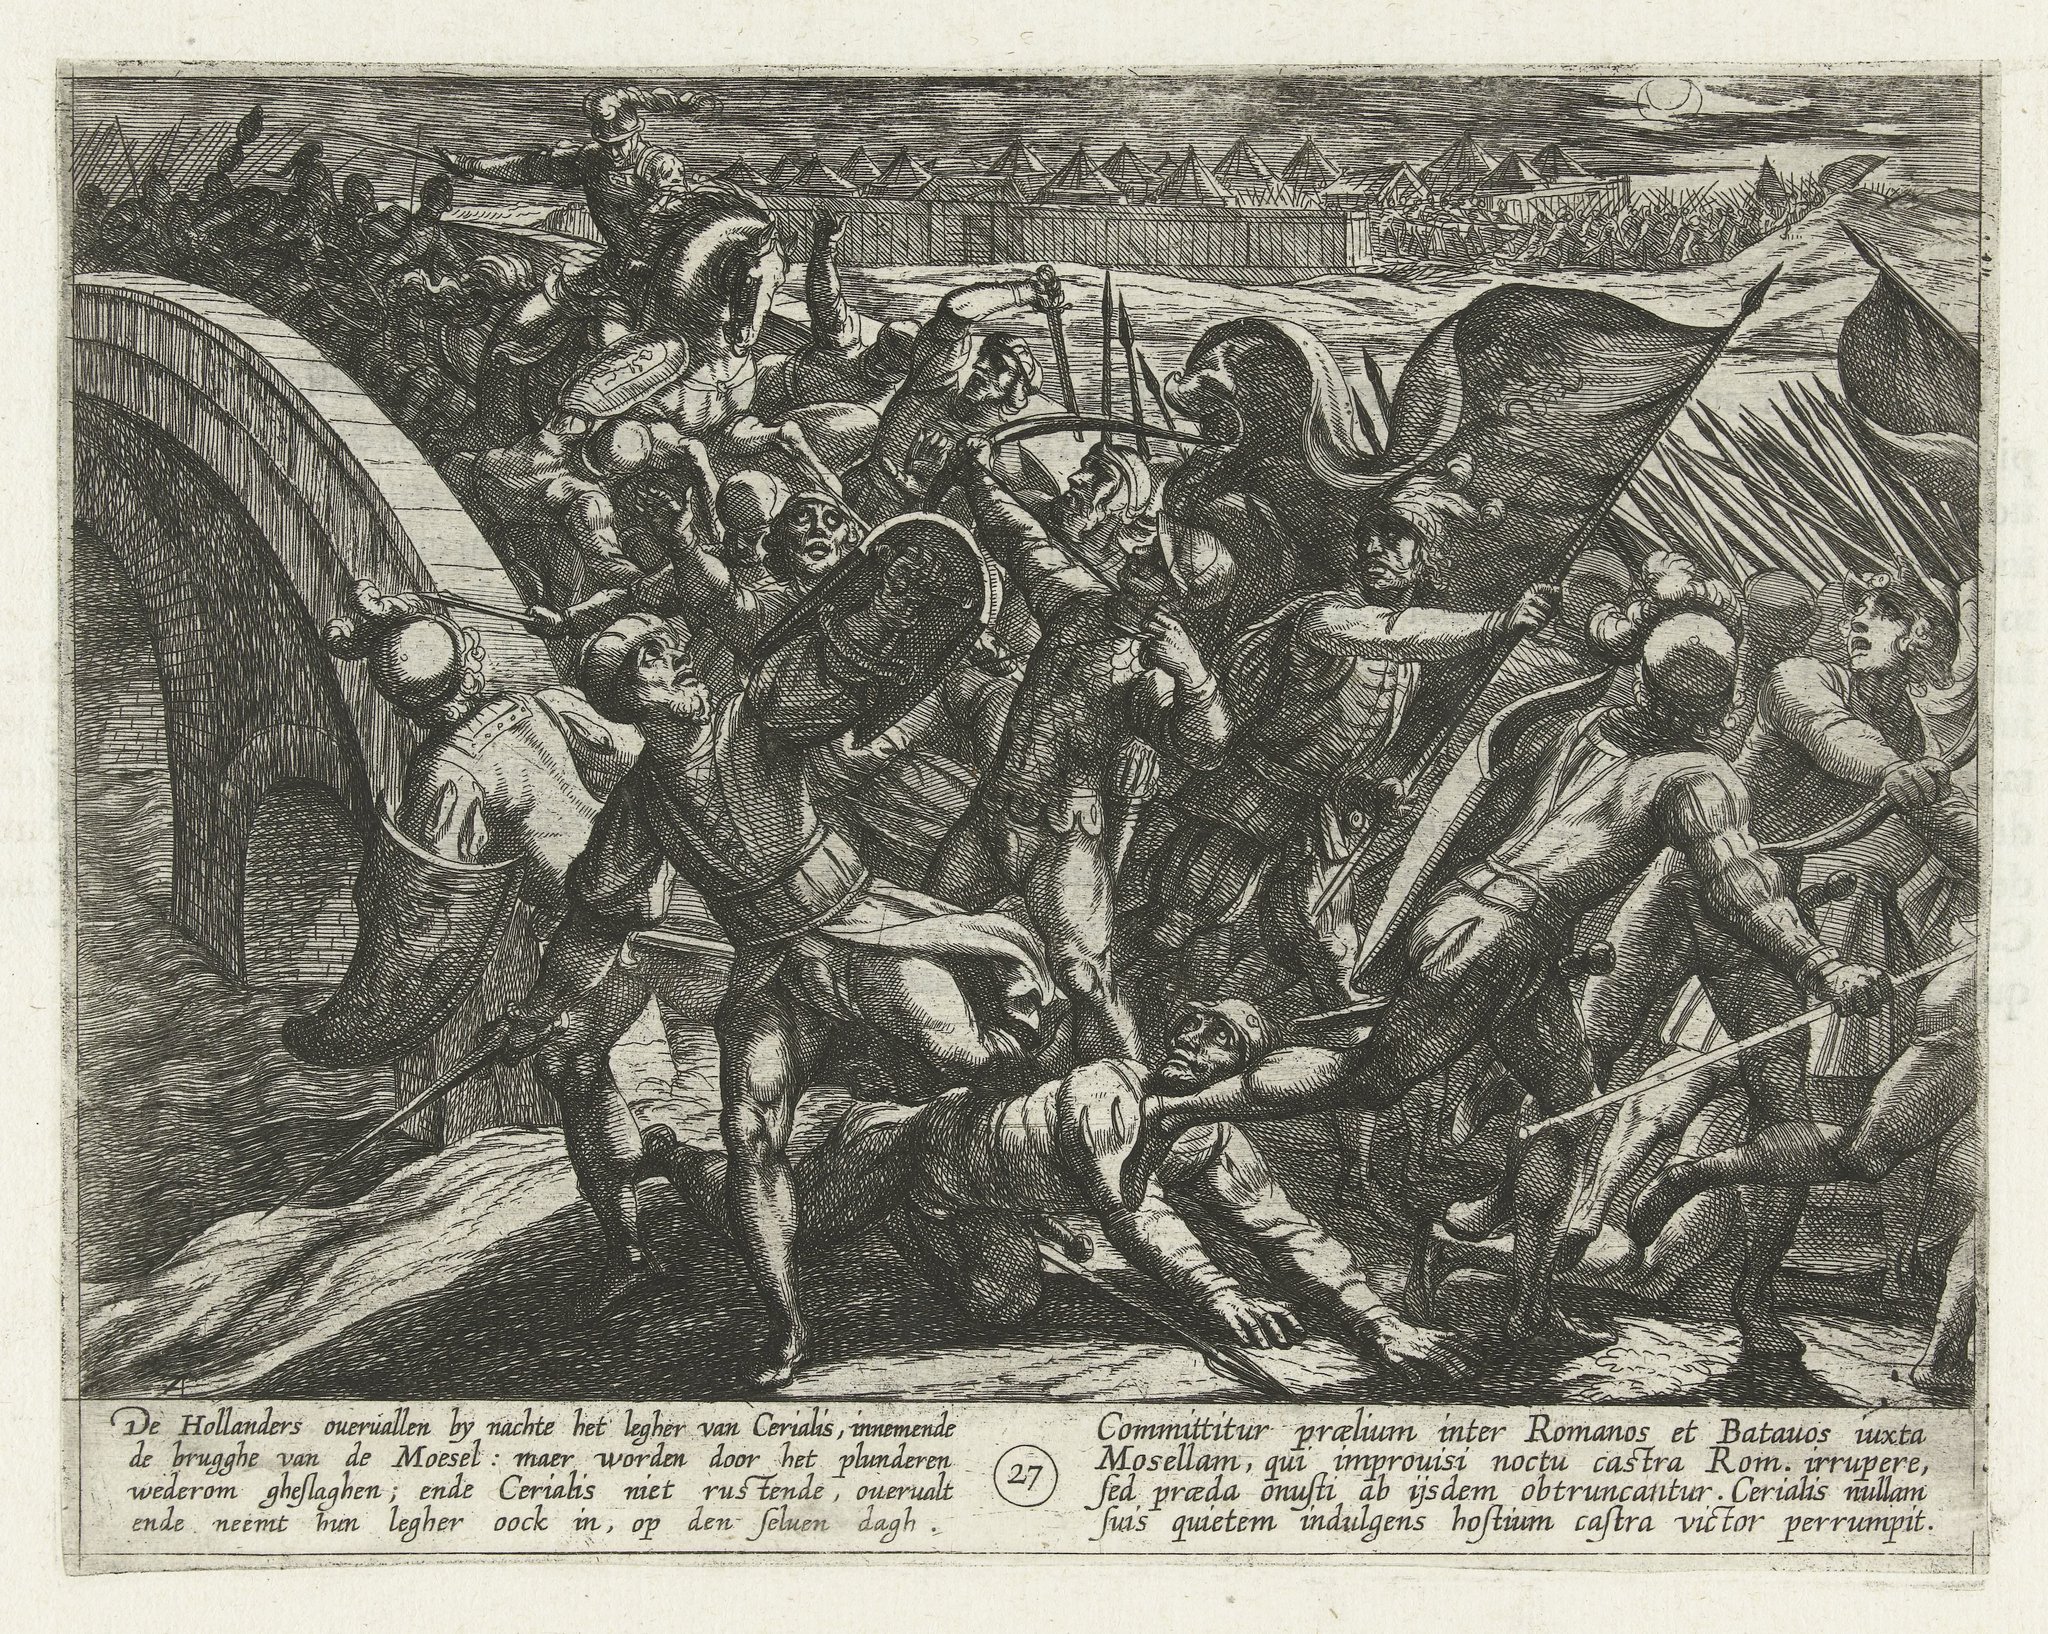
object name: print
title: Romeinen verslagen bij een verrassingsaanval op hun kamp aan de Moezel, 69-70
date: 1612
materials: paper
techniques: etching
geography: italy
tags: battle, fighting in general, extinct, 'historical' peoples (with name), netherlands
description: De Romeinen worden aanvankelijk verslagen bij een verrassingsaanval op hun kamp aan de Moezel, maar slaan dezelfde dag weer terug. Prent nummer 27 in de serie prenten over de Bataafse Opstand: Batavorum cum Romanis bellum / à Corn. Tacito lib. IV & V. : Hist. olim descriptum, figuris nunc aeneis expressum, auctore Othone Vaenio Lugdunobatava = De Batavische oft oude Hollandtsche oorloghe teghen de Romeynen. Otto Vaenius, Antwerpen 1612. Onderaan twee verzen van vier regels in het Nederlands en in het Latijn. Op de achterzijde tekst in het Latijn.